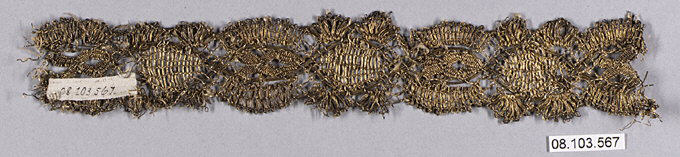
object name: piece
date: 1701-1800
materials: metal thread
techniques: lace